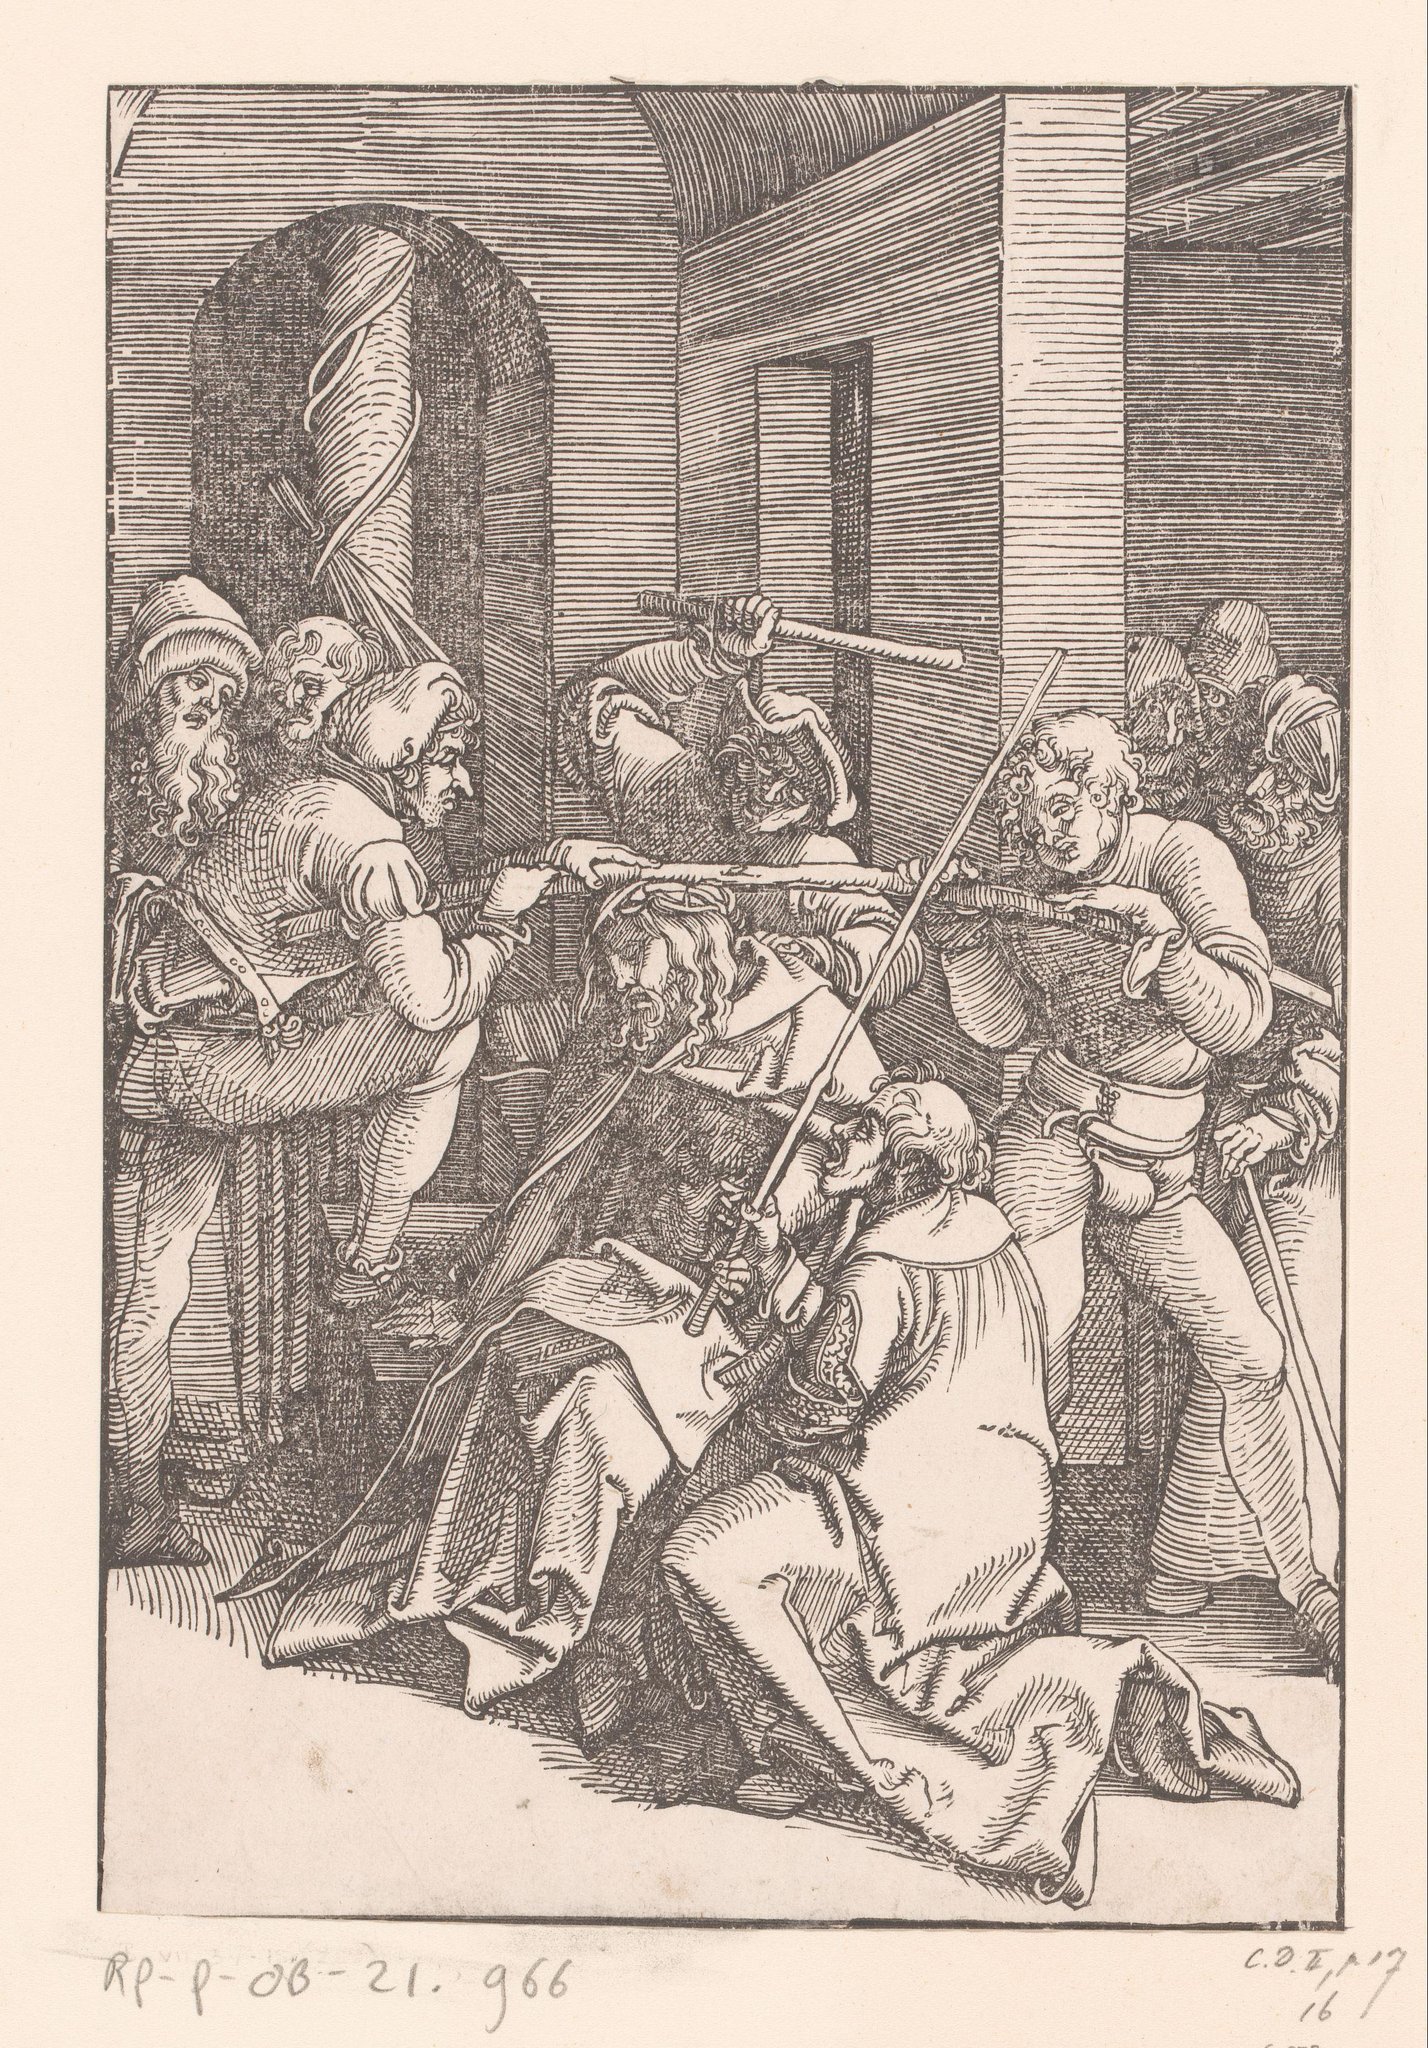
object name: print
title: Doornenkroning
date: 1506-1507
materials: paper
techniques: woodcut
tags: the crowning with thorns: soldiers with sticks place a thorny crown on christ's head and give him a reed (matthew 27:27-31; mark 15:16-20; john 19:2-3)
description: Prent voor het eerst gebruikt in: Speculum Passionis. Neurenberg: Ulrich Pinder, 1507.